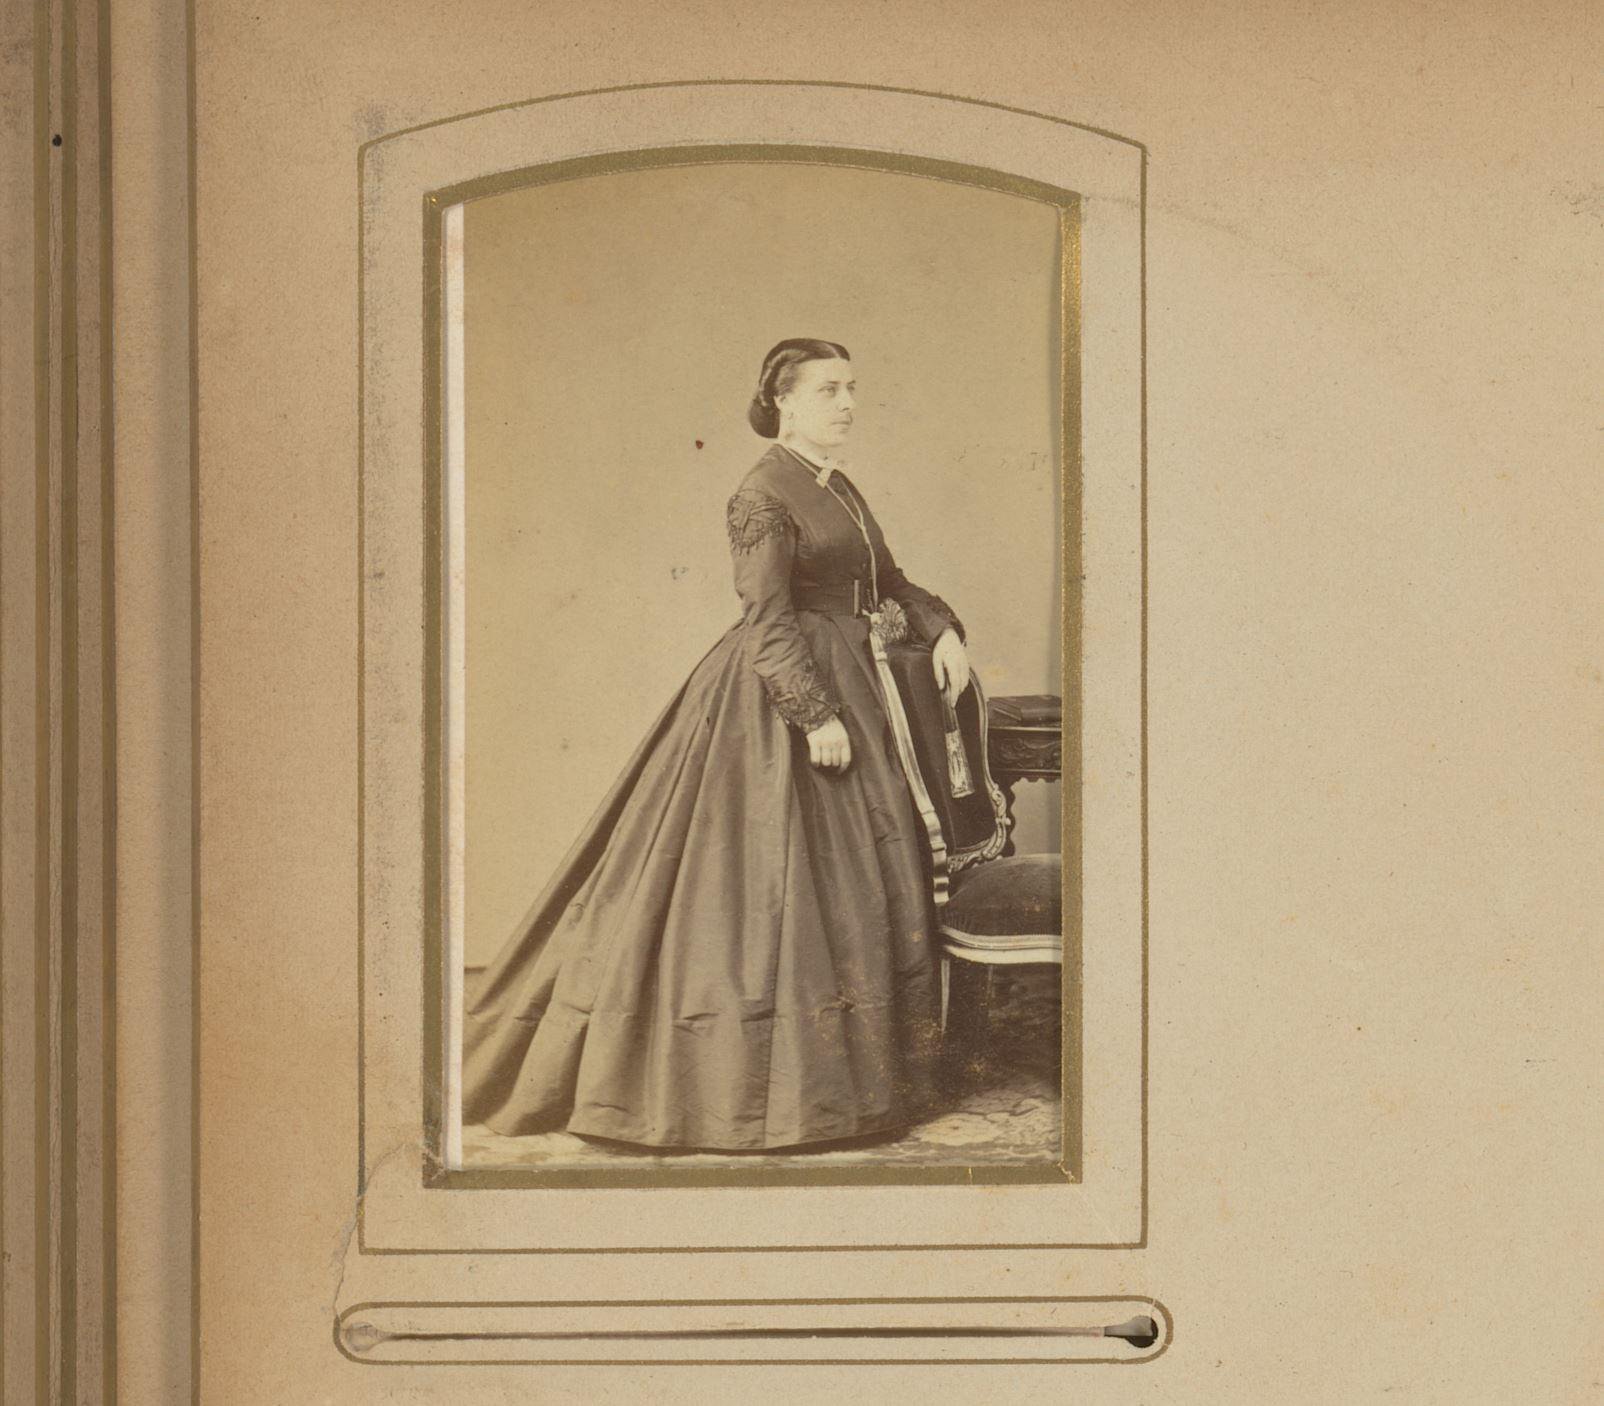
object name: album leaf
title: Portret van een vrouw, staand bij een stoel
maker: césar mitkiewicz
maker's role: fotograaf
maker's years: 1836-1871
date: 1863-1867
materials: cardboard, photographic support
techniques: albumen print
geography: brussels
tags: historical persons - bb - woman, standing figure - aa - female human figure, chair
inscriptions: inscription: ‘CESAR MITKIEWICZ & Cie/ PHOTOGRAPHES/ 9, Rue Neuve, 9./ BRUXELLES’